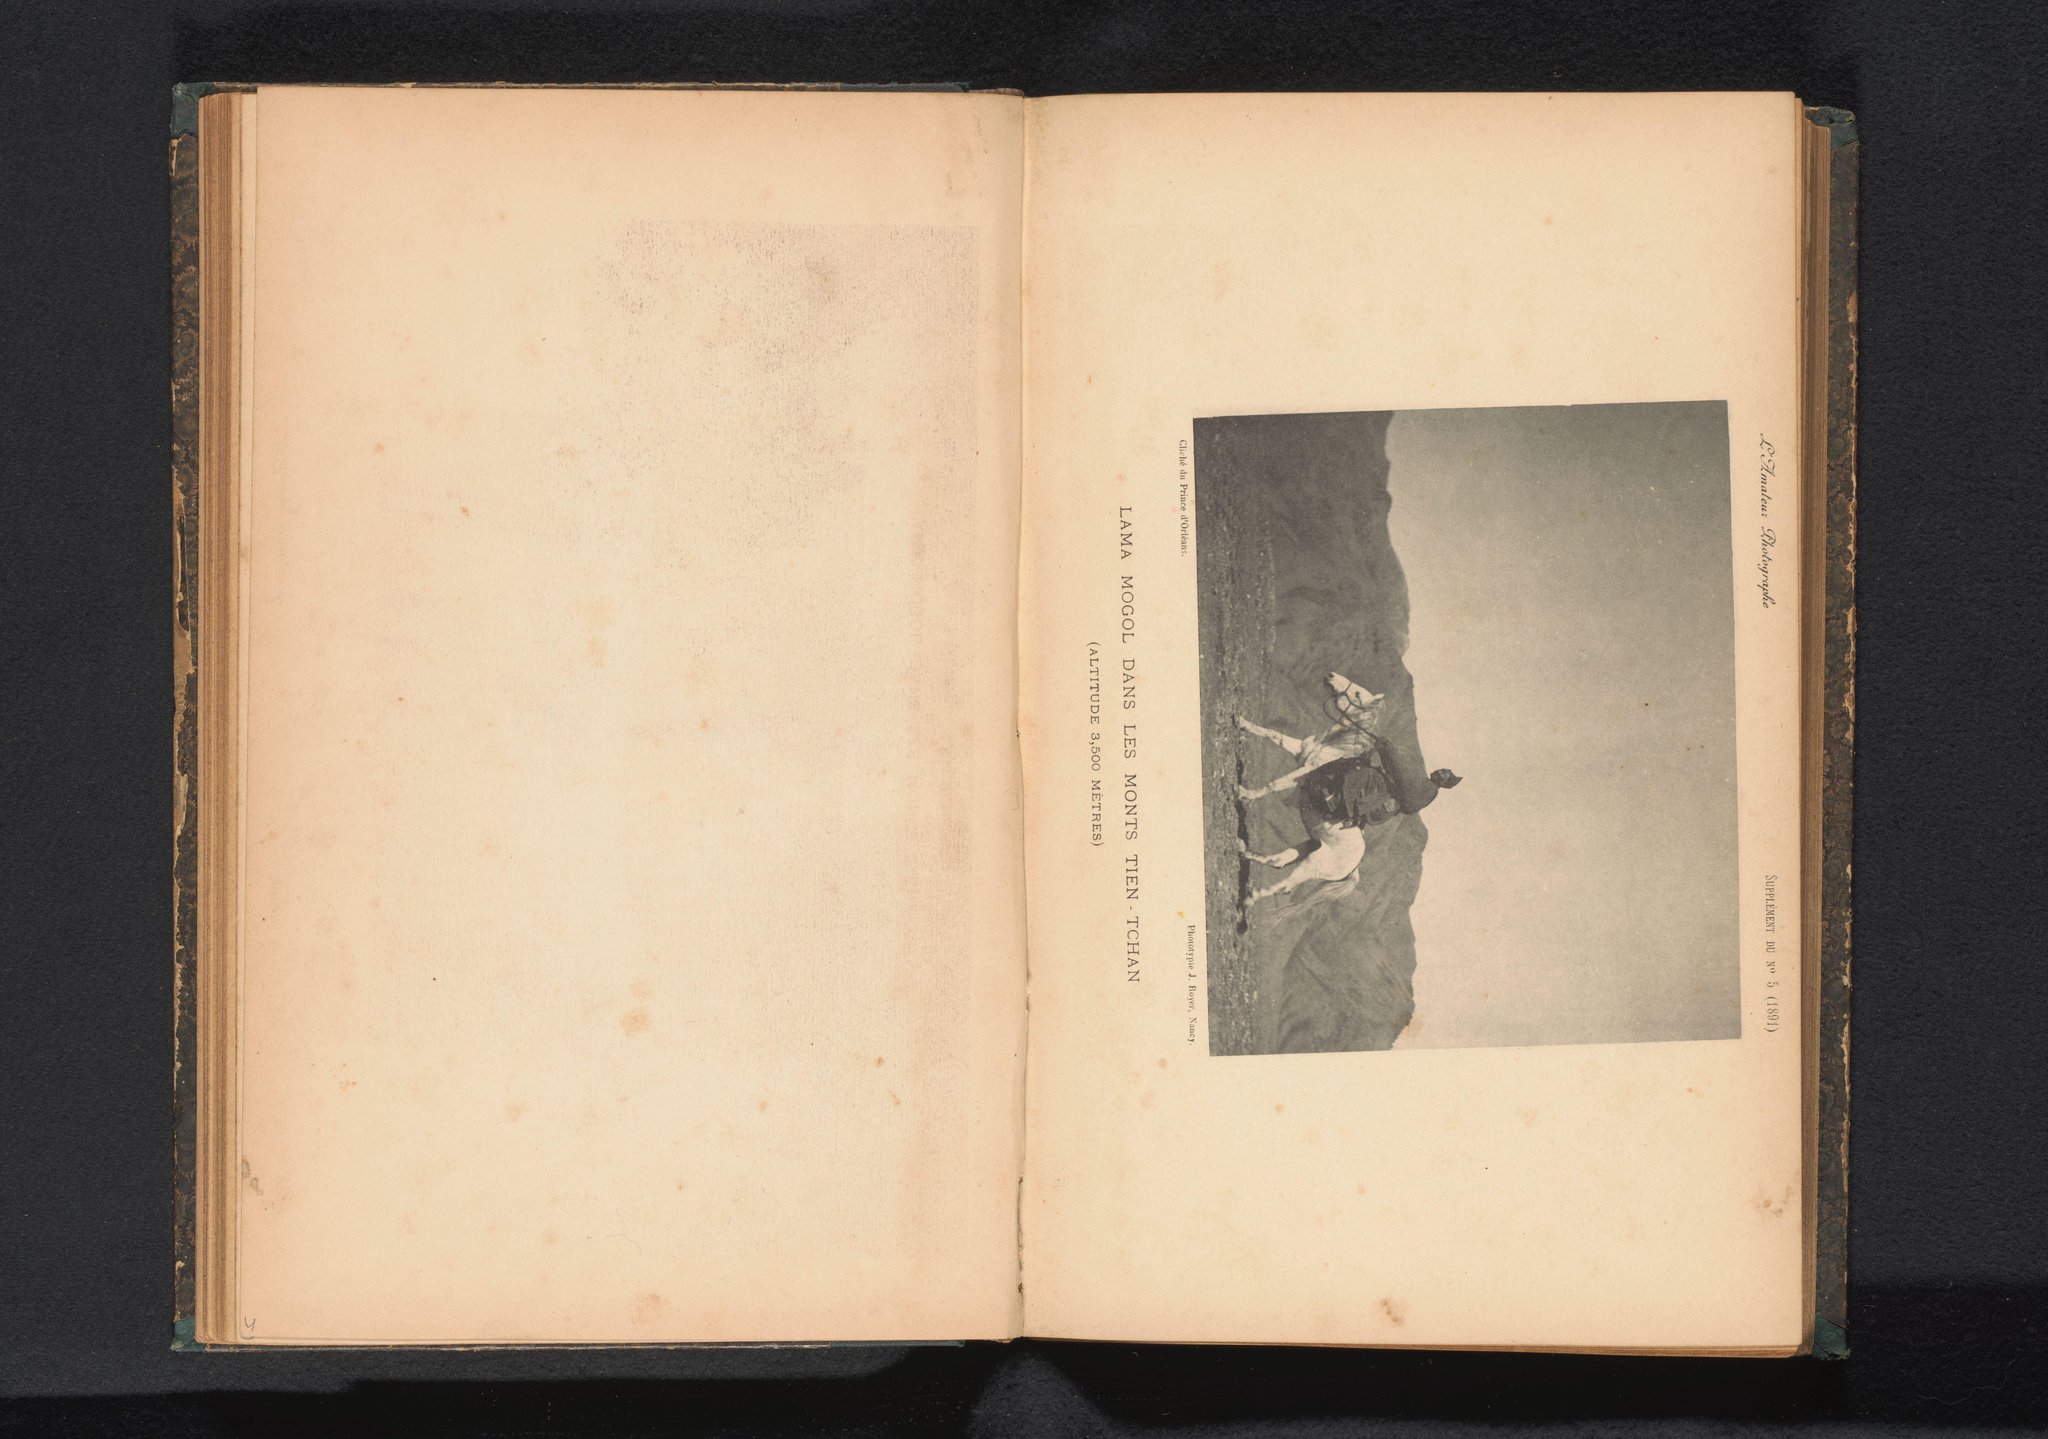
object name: photomechanical print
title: Lama mogol dans les monts Tien-Tchan (altitude 3,500 mètres)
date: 1886-1891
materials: paper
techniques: photograph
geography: nancy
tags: riding a horse, ass, or mule; rider, horseman, mountains